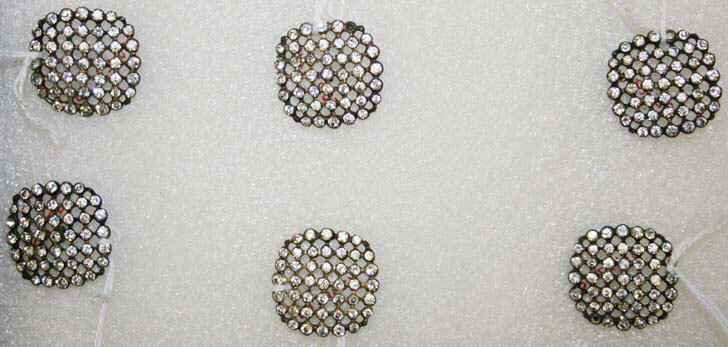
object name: button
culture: french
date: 1775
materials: metal